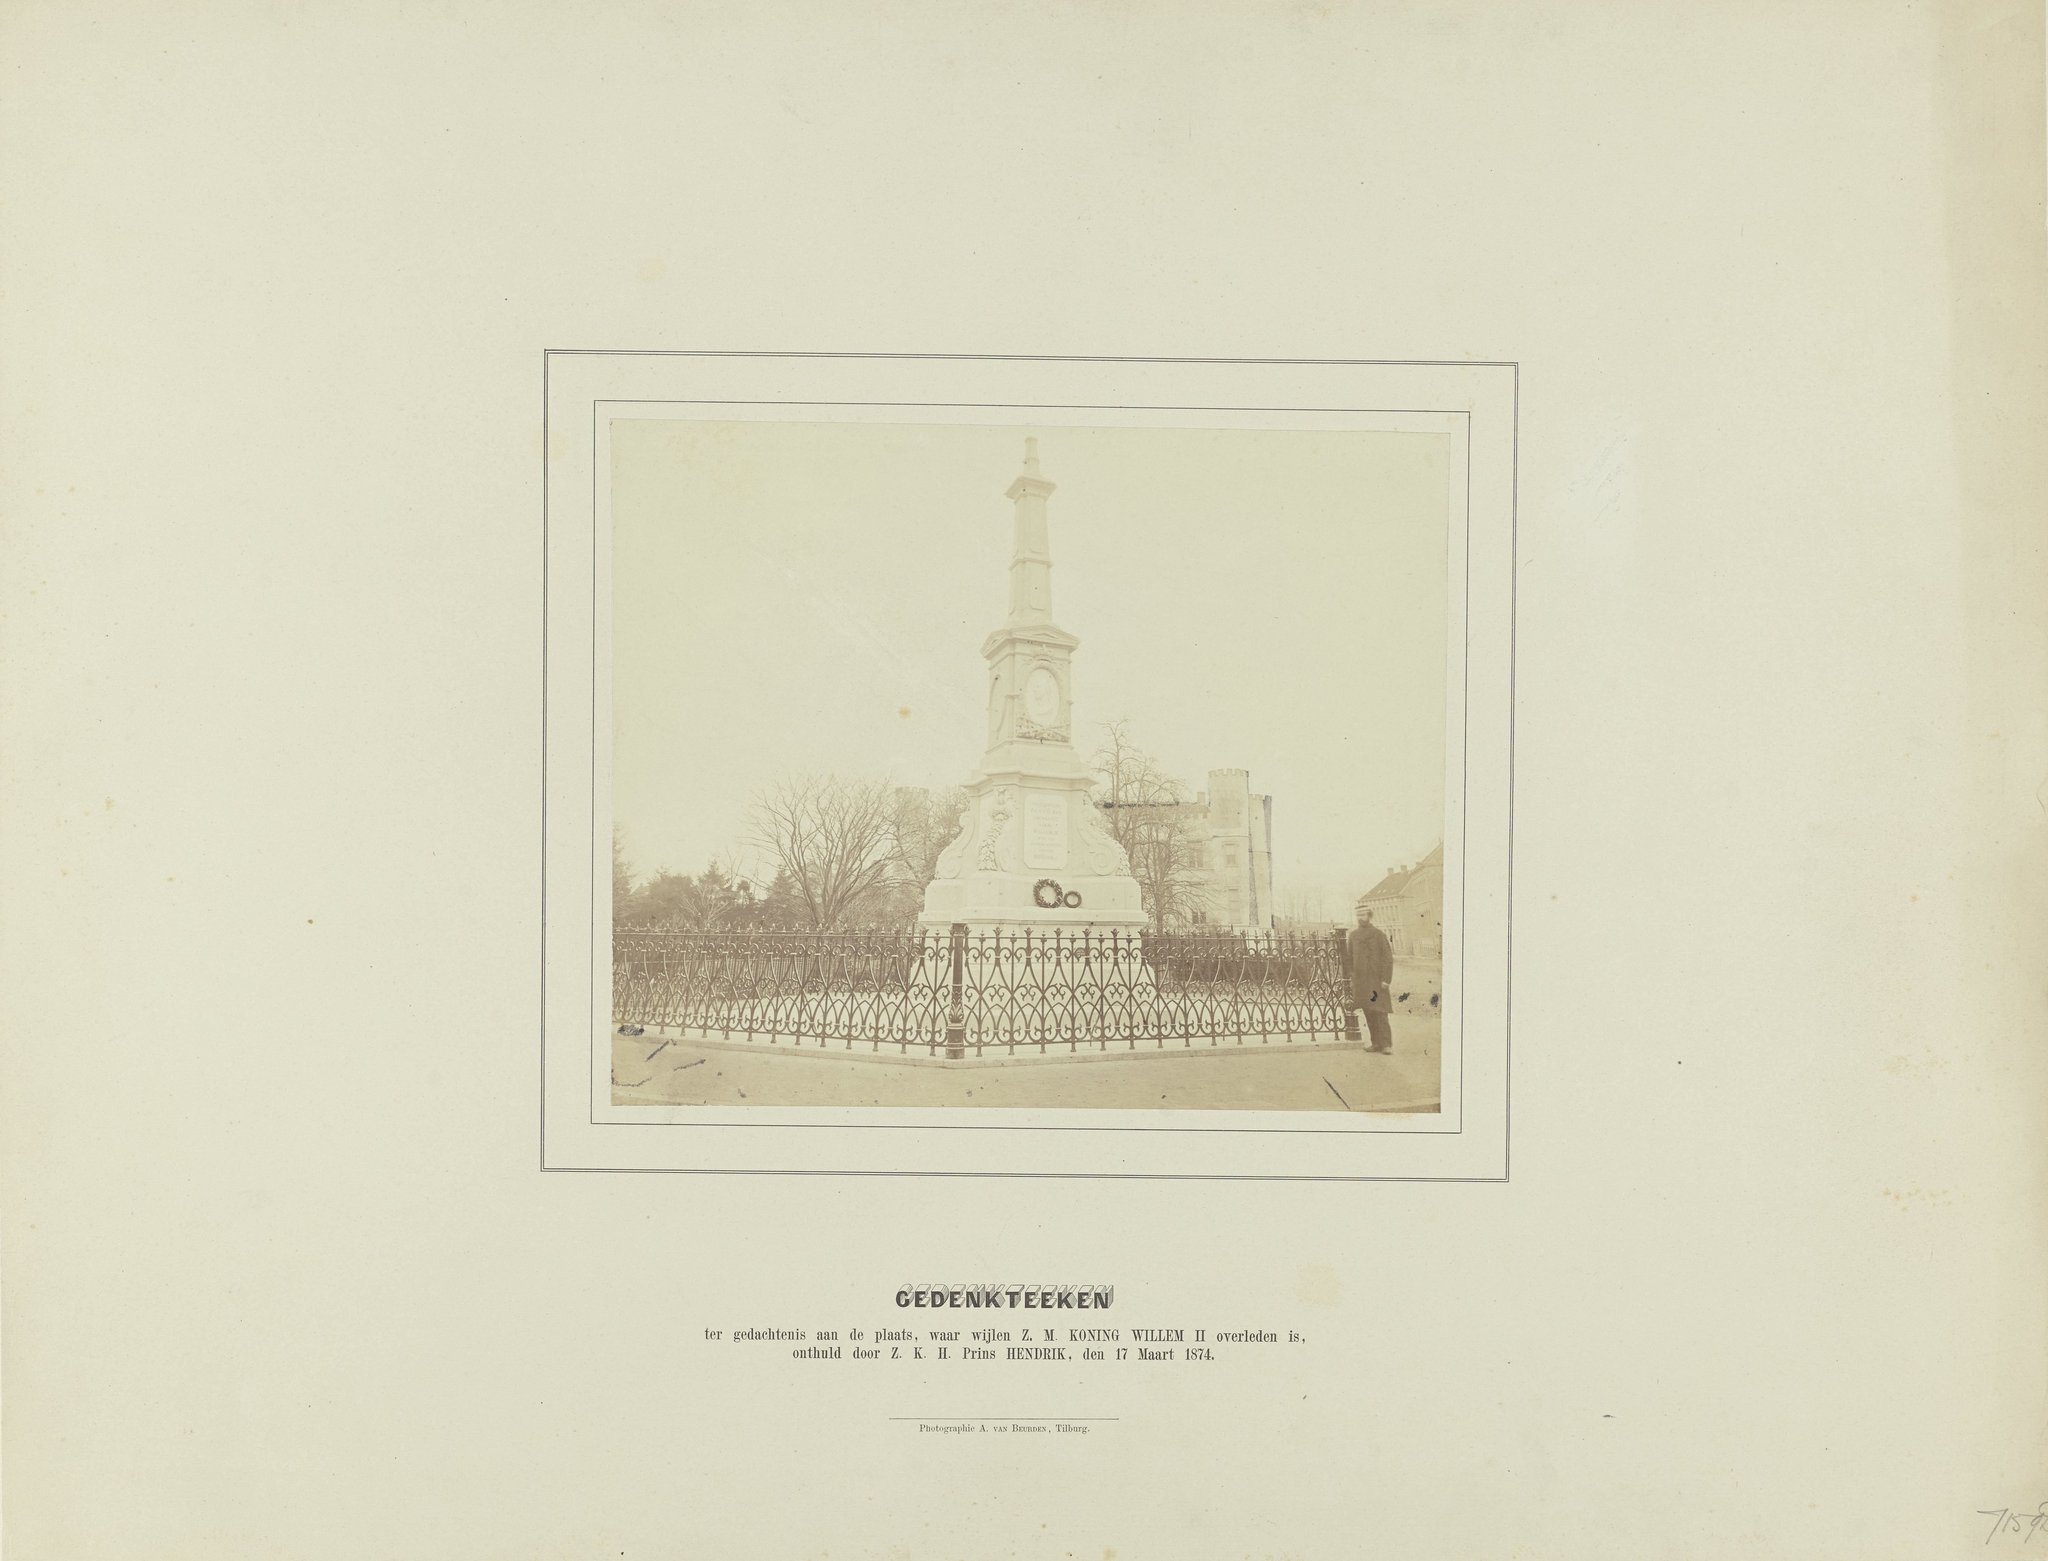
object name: photograph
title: Gedenkteeken ter gedachtenis aan de plaats, waar wijlen Z.M. Koning Willem II overleden is, onthuld door Z.K.H. Prins Hendrik, den 17 Maart 1874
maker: adrianus van beurden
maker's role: fotograaf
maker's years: 1843-1915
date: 1874-1880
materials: cardboard, paper, photographic support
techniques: albumen print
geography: tilburg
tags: monument, statue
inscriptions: collector's mark: Lugt 2233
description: Gedenkteken opgericht op de plaats waar het sterfhuis van koning Willem II in Tilburg heeft gestaan (gesloopt in 1873), onthuld door Prins Hendrik op 17 maart 1874. 25 jaar na het overlijden van de koning op 17 maart 1849. Zie ook de pendant.